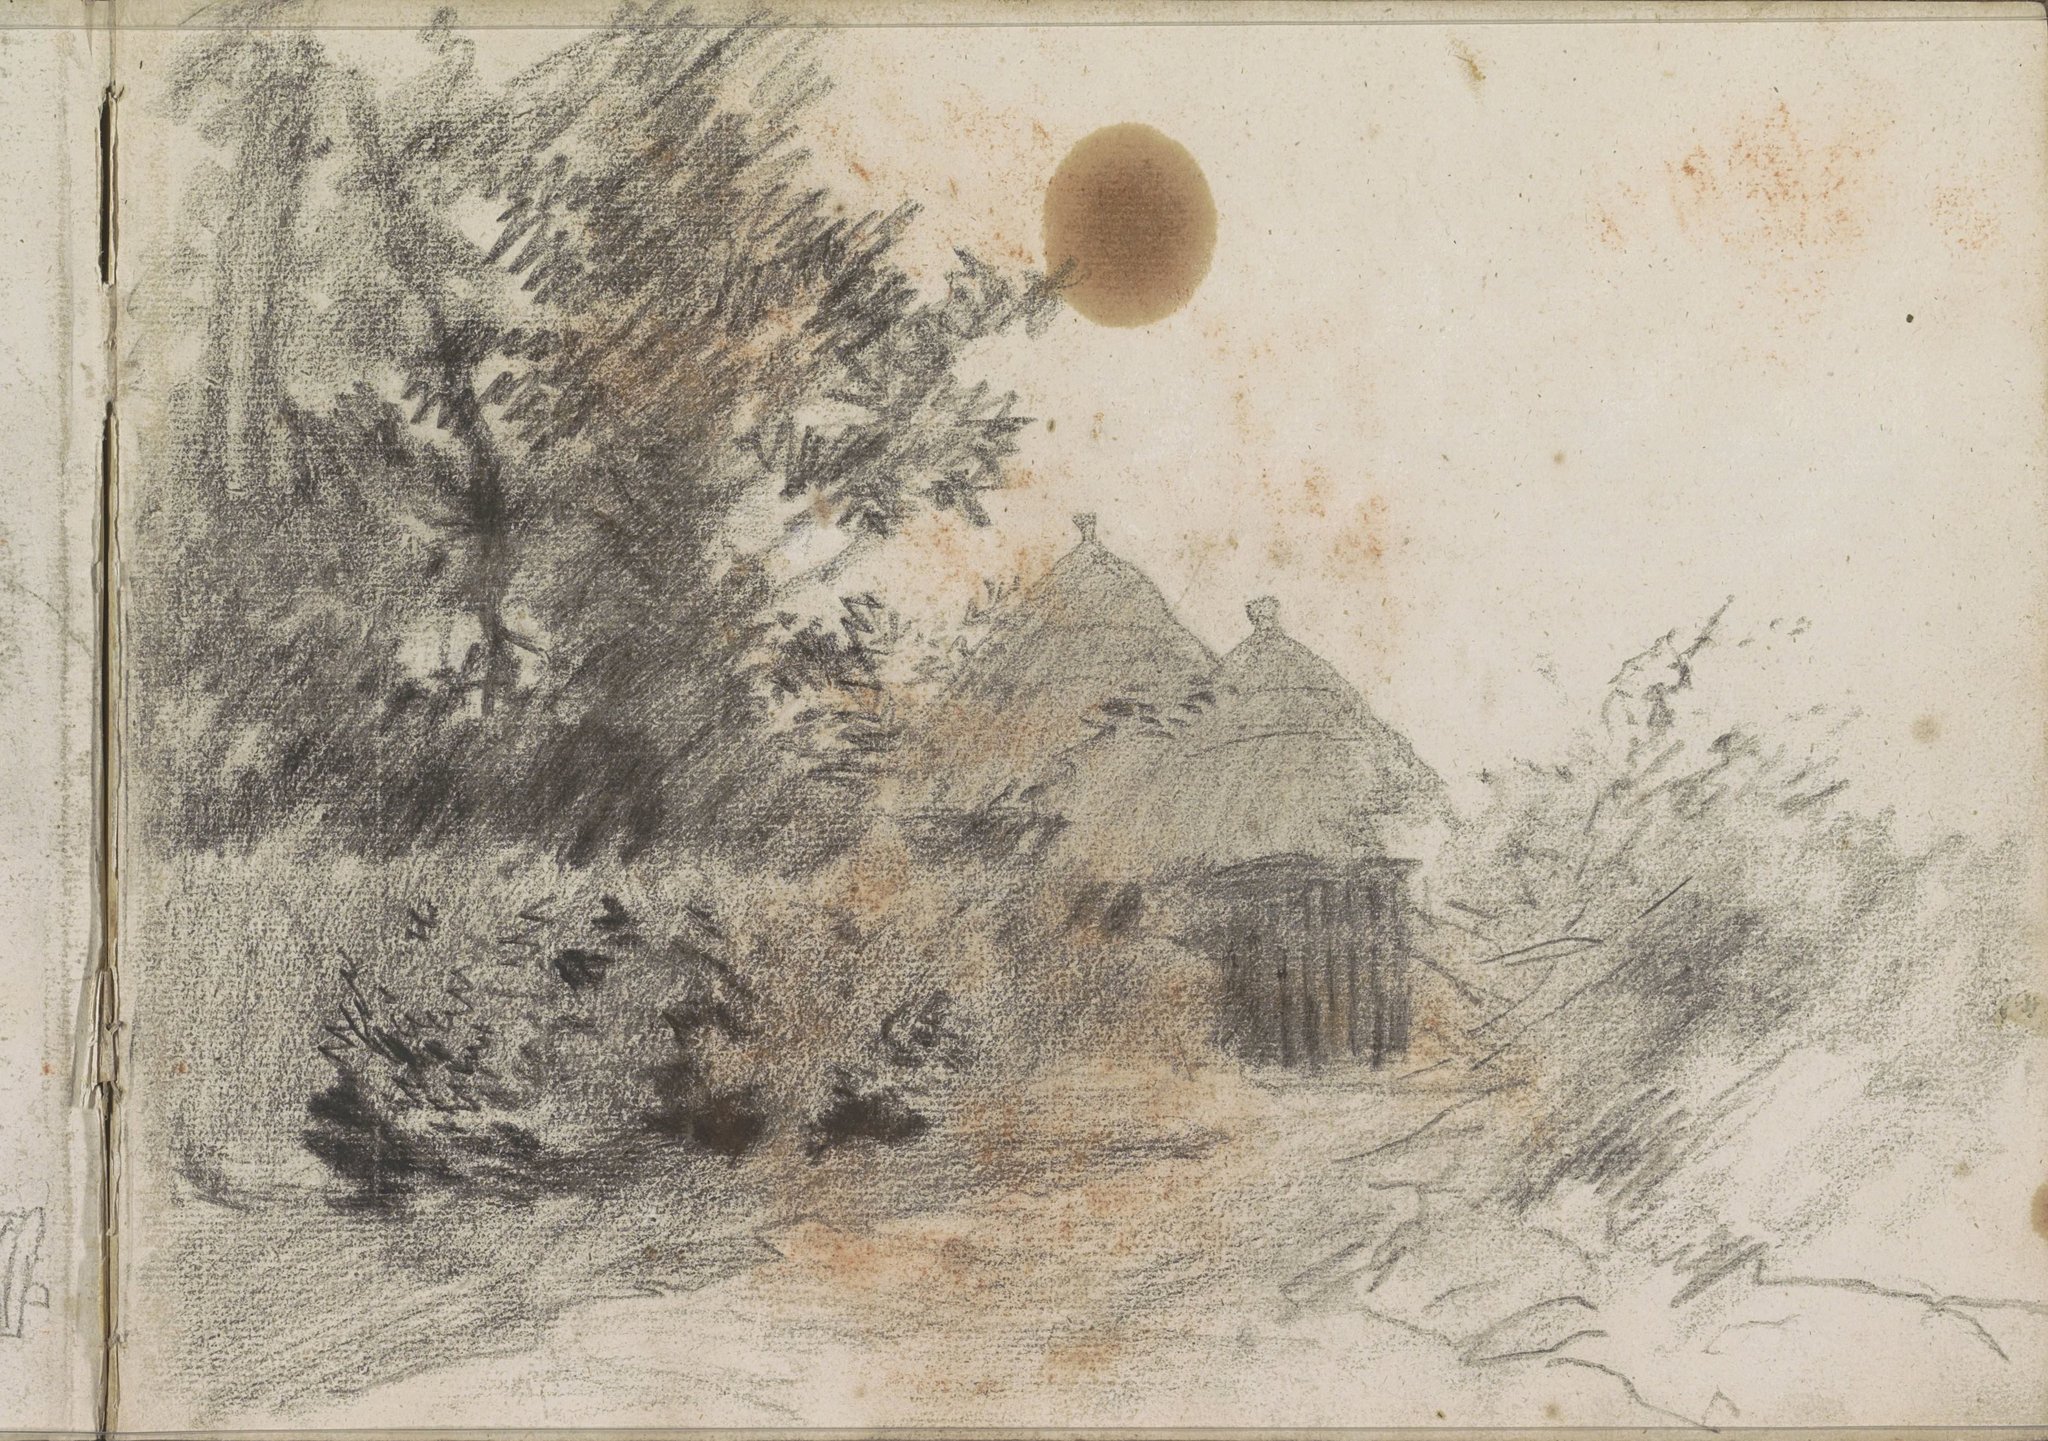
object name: sketchbook leaf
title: Pad langs een heg naar een plattelandswoning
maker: anton mauve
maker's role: draughtsman, painter, print maker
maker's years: 1838-1888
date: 1848-1888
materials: chalk, paper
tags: road, path, farm or solitary house in landscape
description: Blad 1 recto uit een schetsboek met 34 bladen.